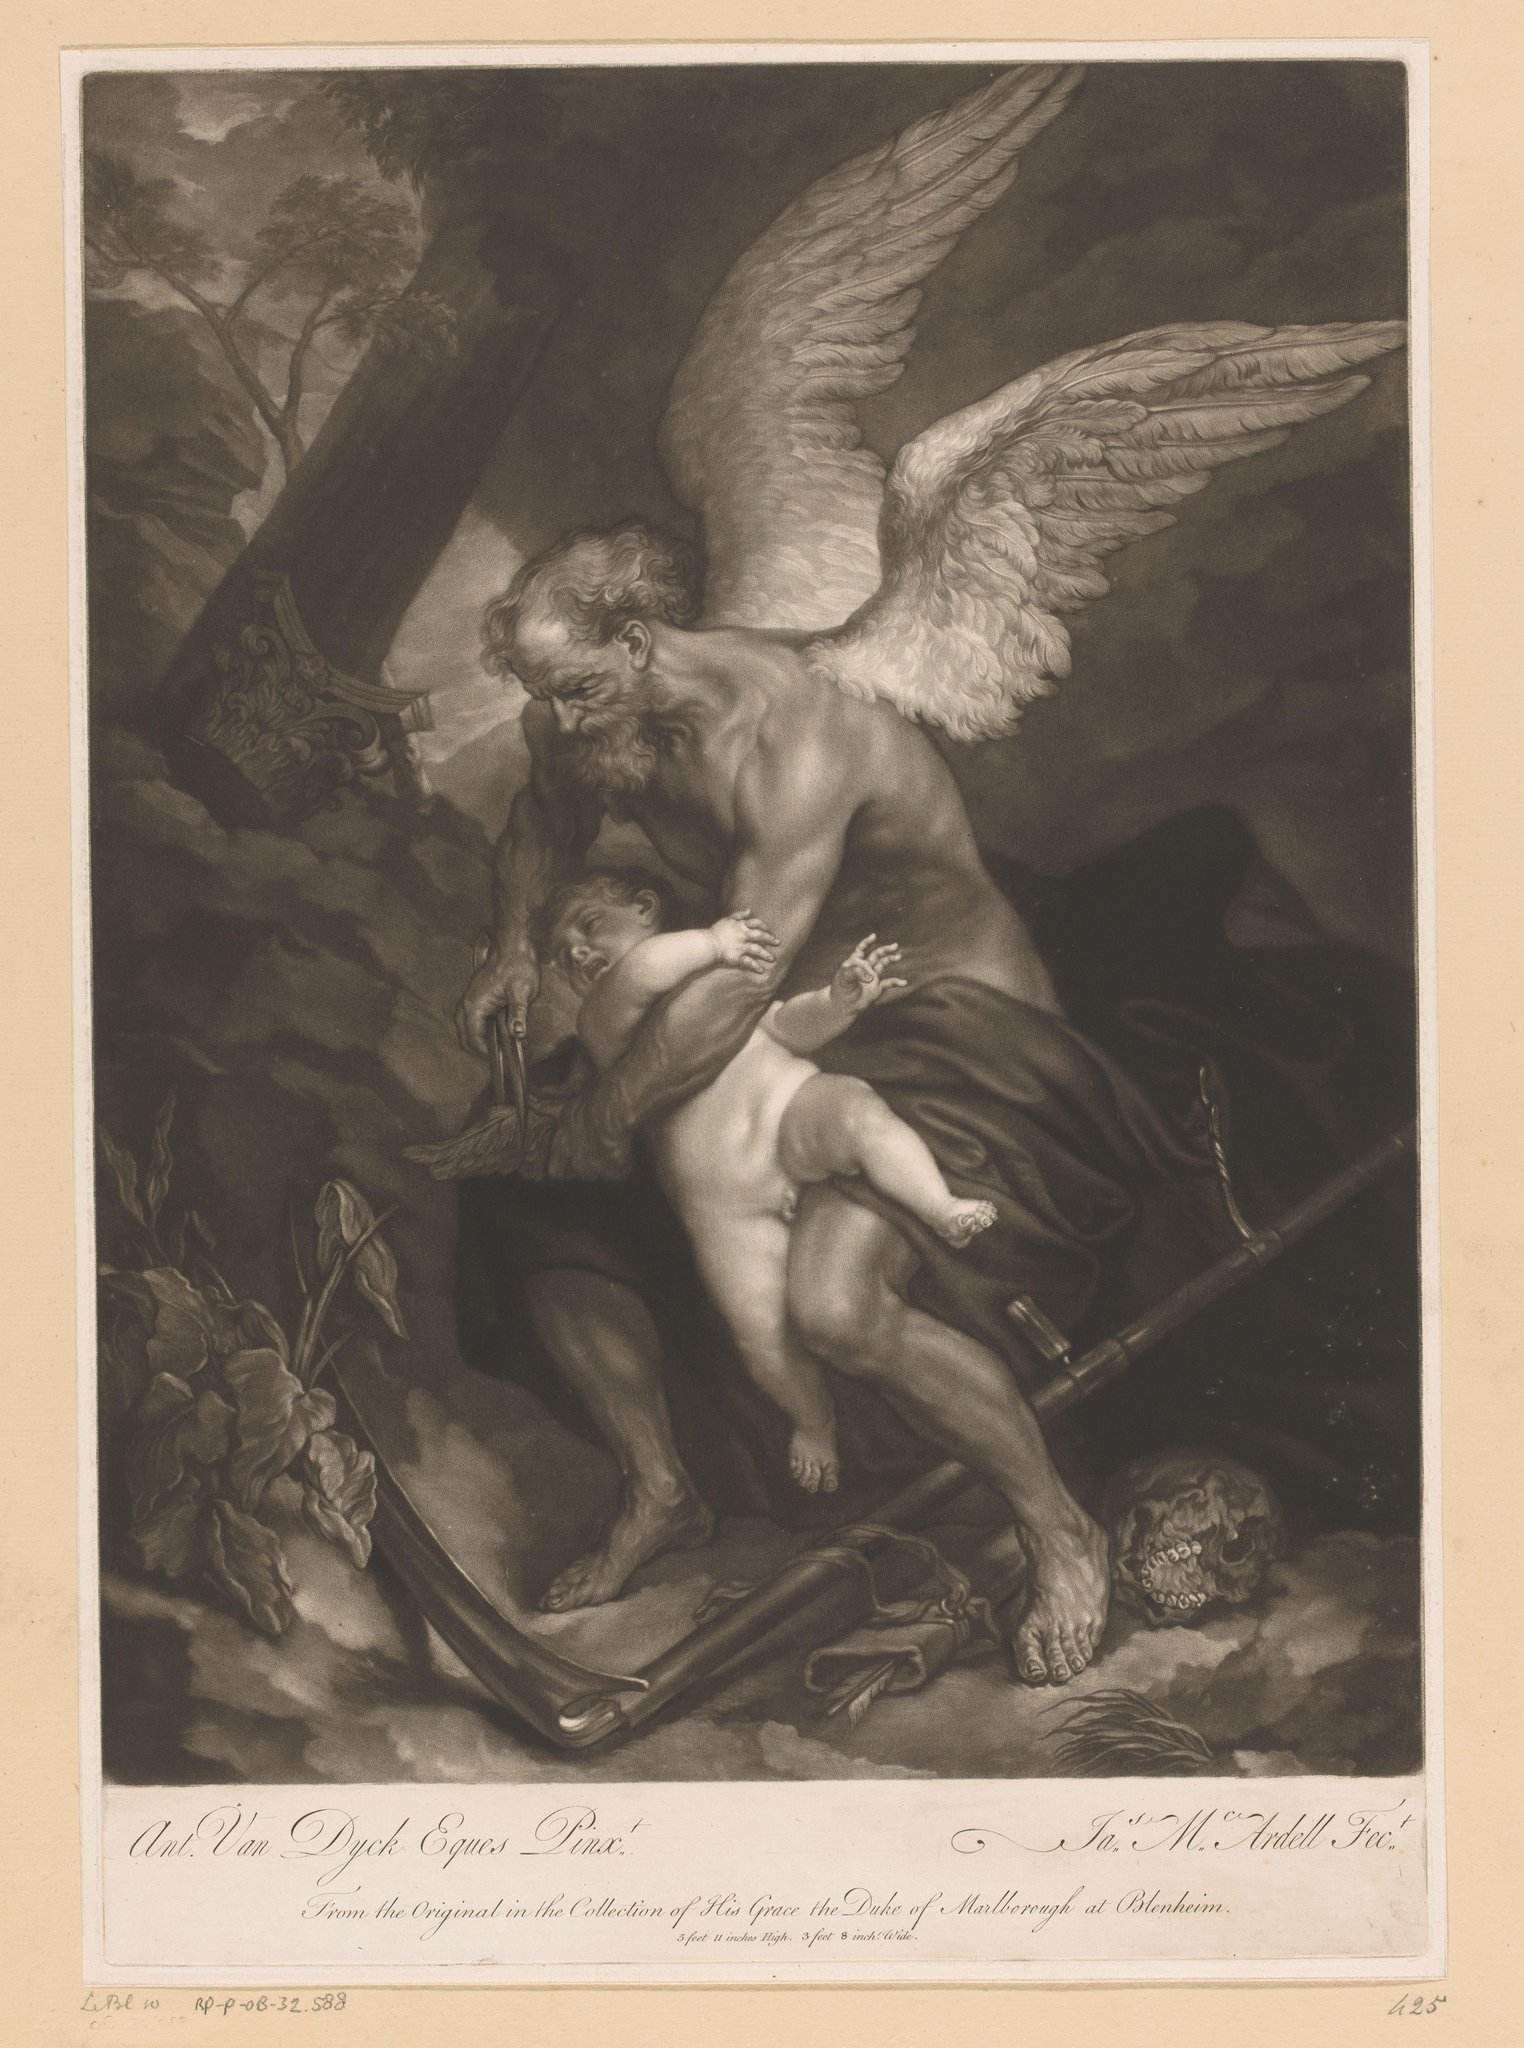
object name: print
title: Tijd knipt de vleugels van Cupido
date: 1745-1765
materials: paper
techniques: mezzotint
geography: london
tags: punishment of cupid, father time, man with wings and scythe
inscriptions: collector's mark: Lugt 240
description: Christopher Lennox-Boyd suggereert dat de prent beschreven onder Goodwin 209 bestaat uit drie verschillende platen, zie de beschrijving bij R,2.59 in het British Museum.